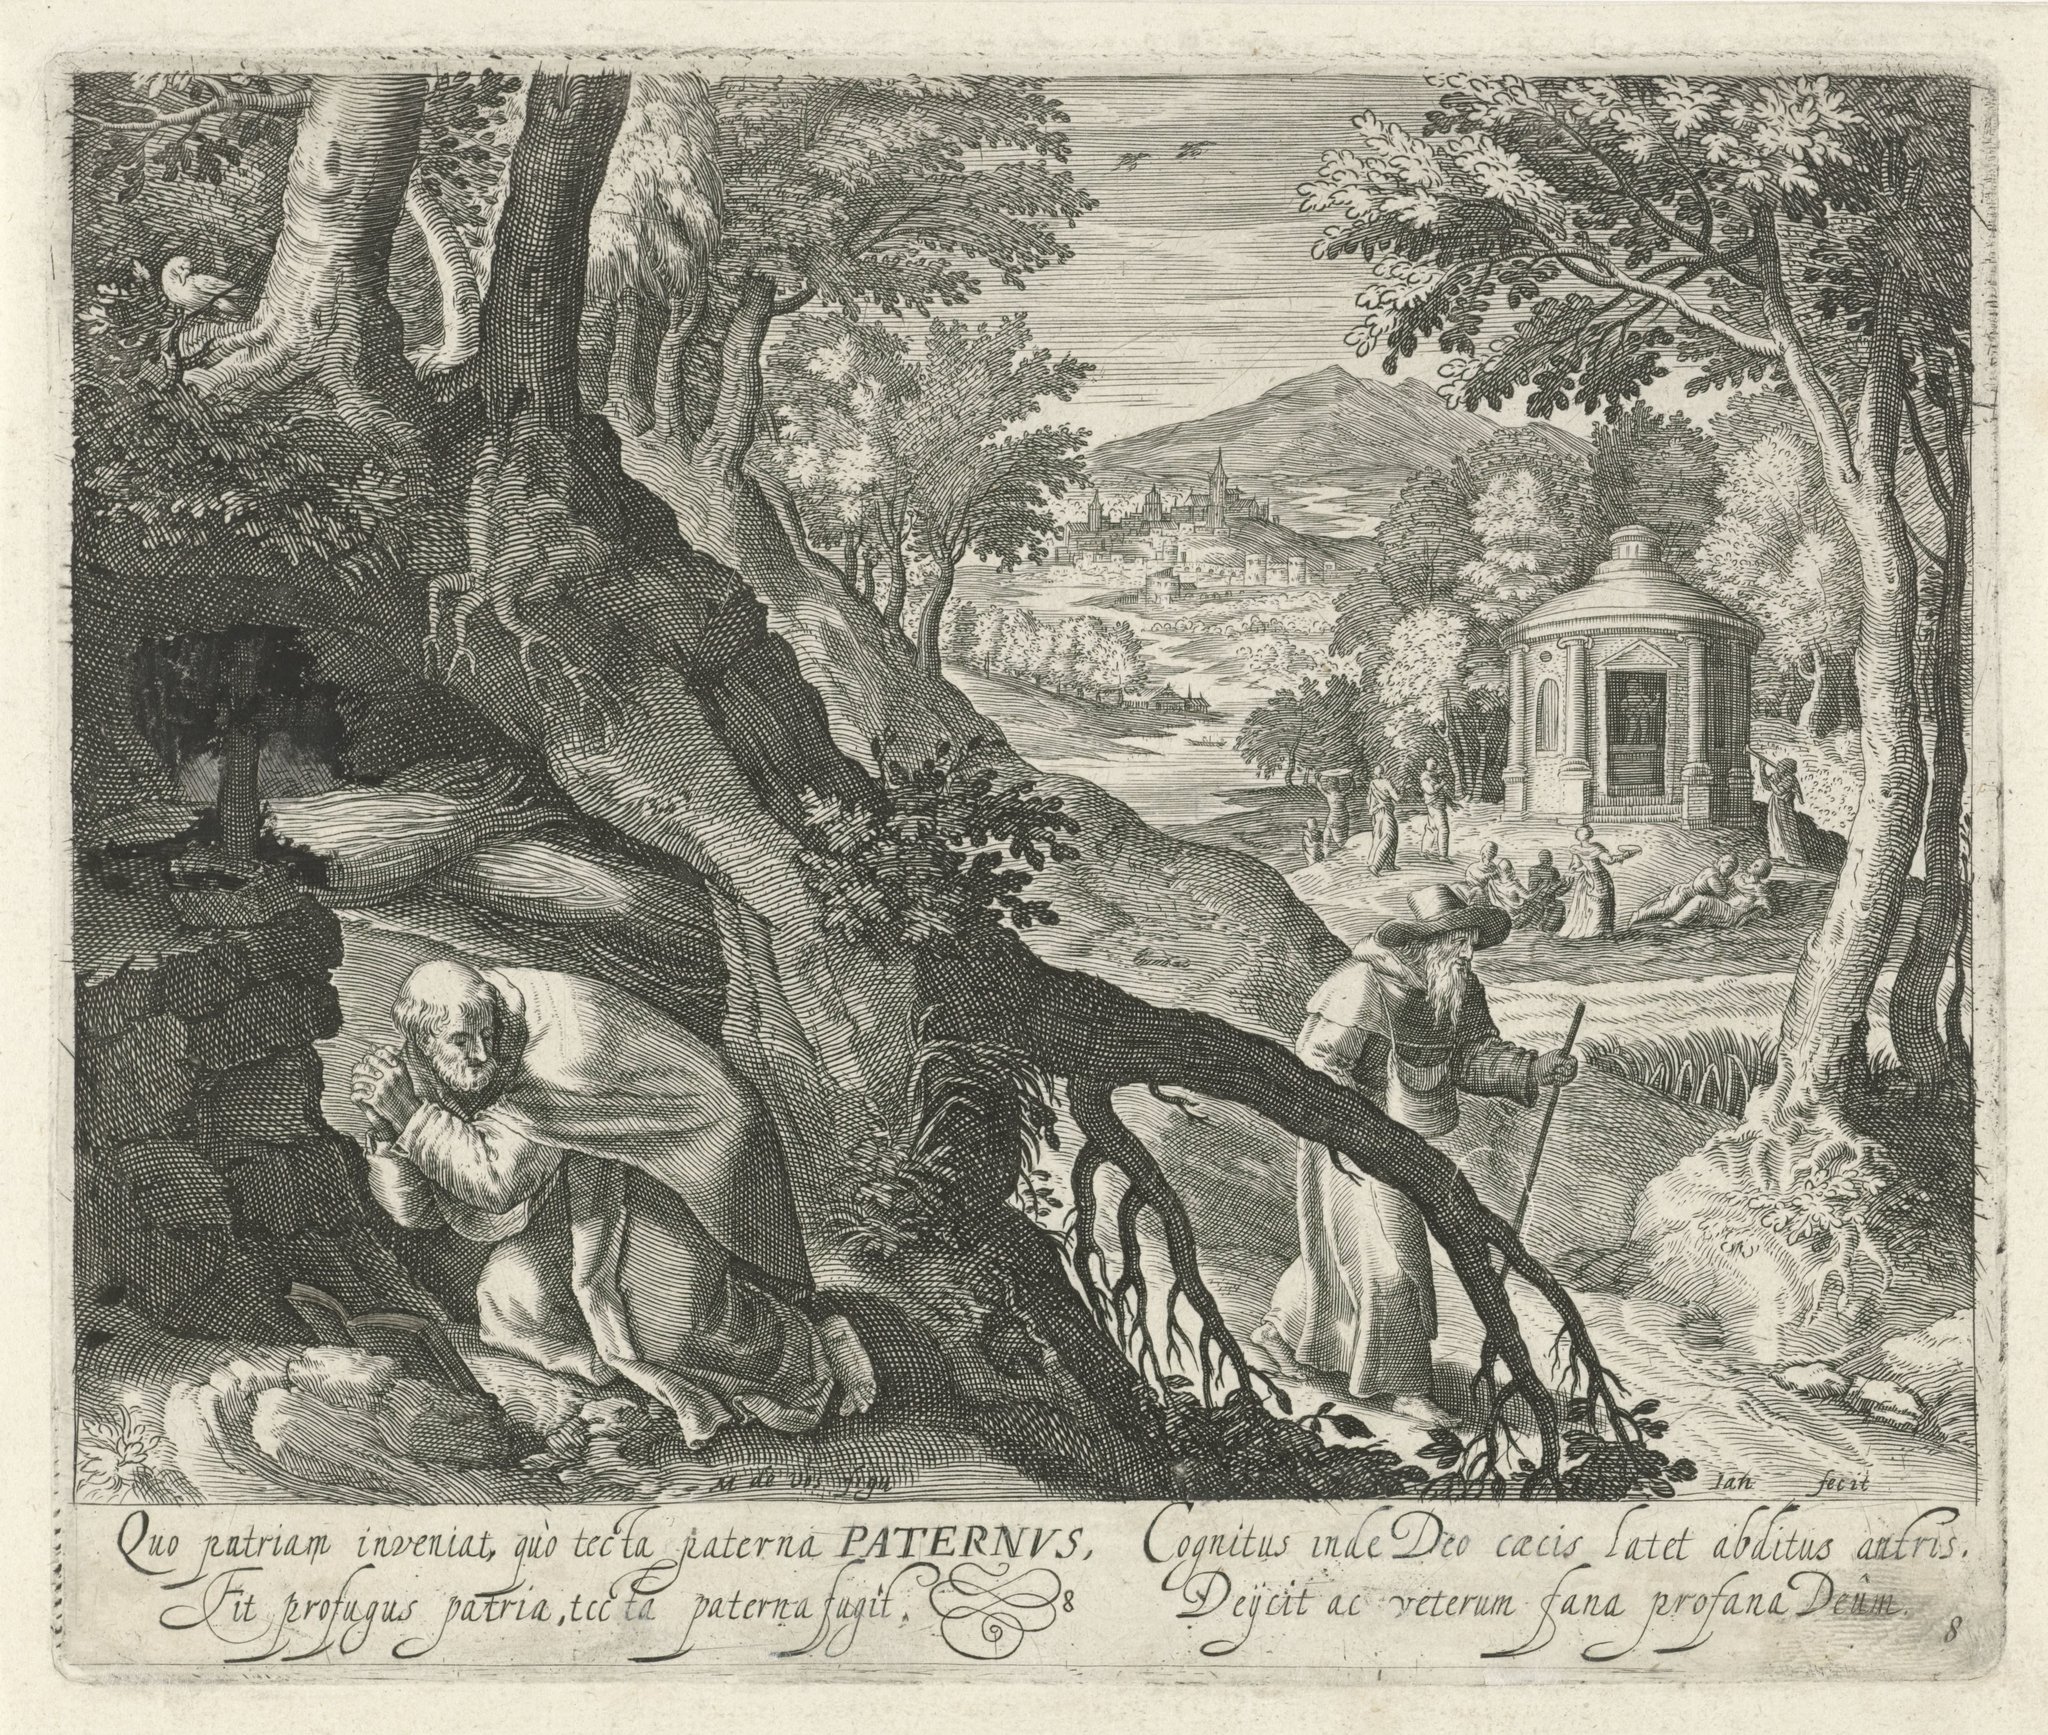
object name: print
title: Heiligen en kluizenaars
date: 1580-1625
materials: paper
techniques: brush, engraving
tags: male saints (with name), monk(s), friar(s), robbery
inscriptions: collector's mark: Lugt 2228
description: Tijdens een van zijn omzwervingen als kluizenaar door de bossen stuit de monnik Paternus van Sens op een groep figuren die een tempel leegrooft. Paternus spreekt de rovers vermanend toe en wordt terstond vermoord. Op de voorgrond is Paternus in gebed neergeknield voor een opengeslagen boek. In de marge een onderschrift in Latijn.